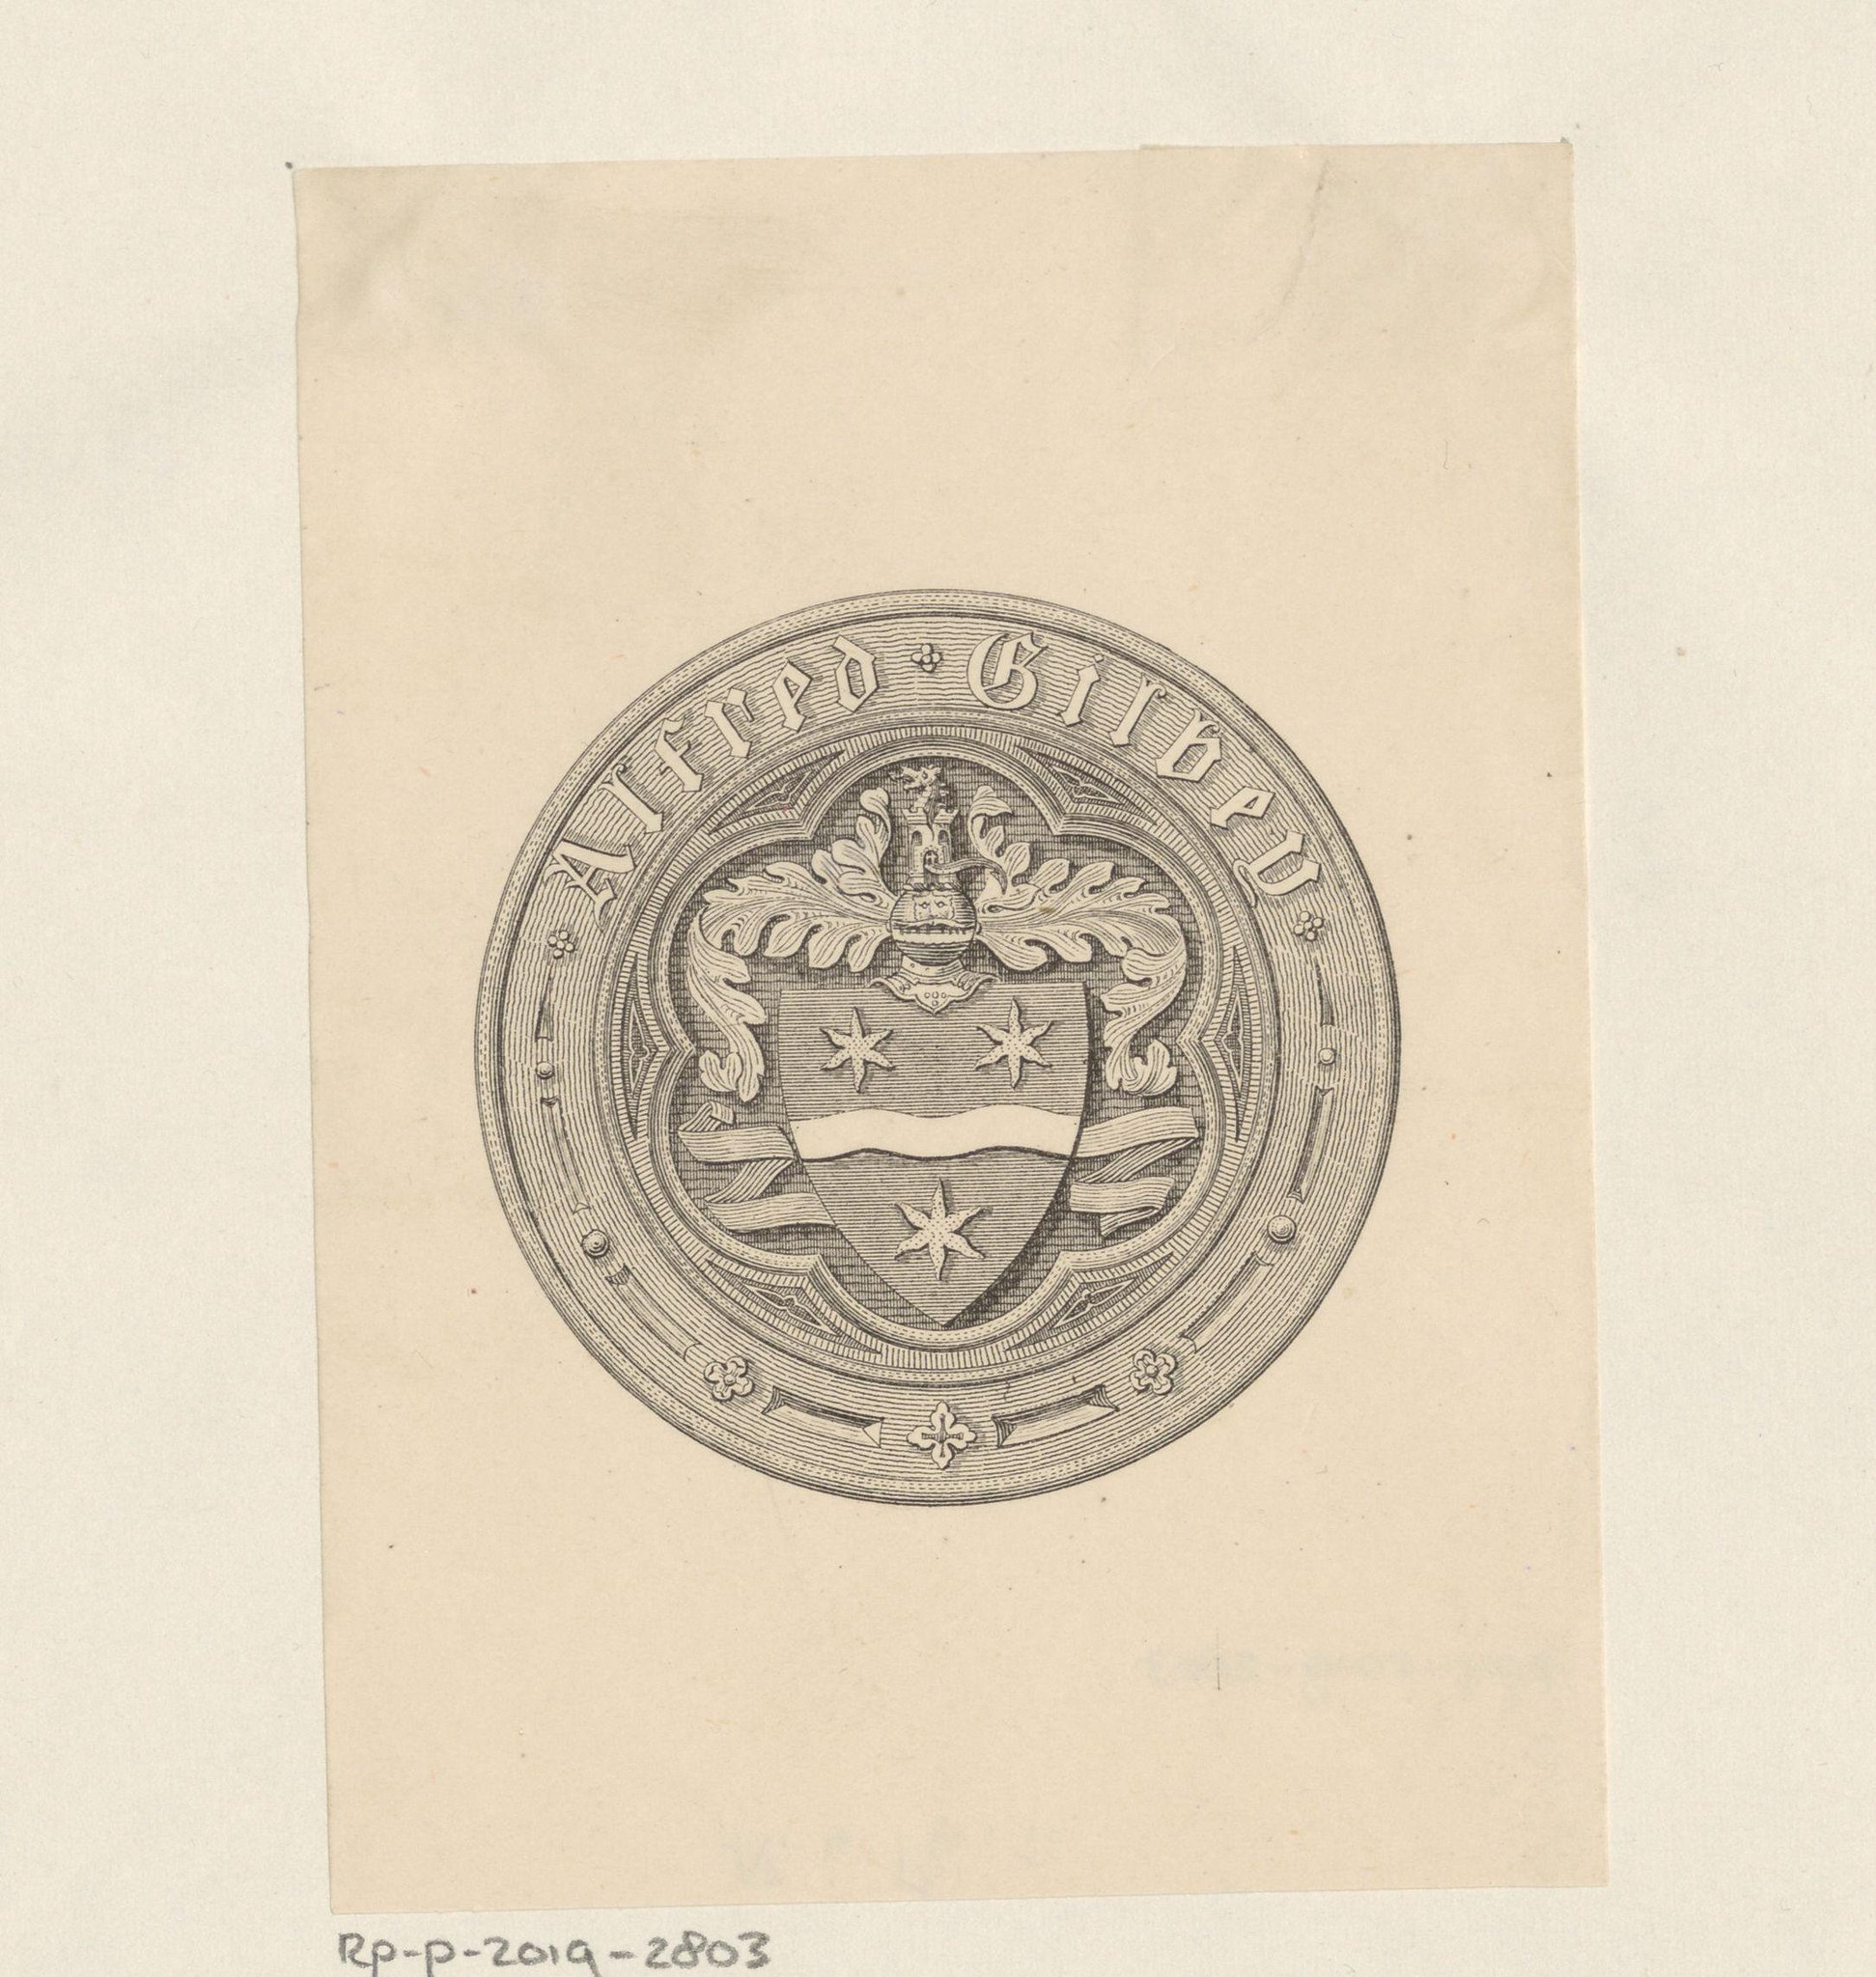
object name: bookplate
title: Ex libris van Alfred Gilbey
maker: Anonymous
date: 1850-1899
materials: paper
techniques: engraving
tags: armorial bearing, heraldry